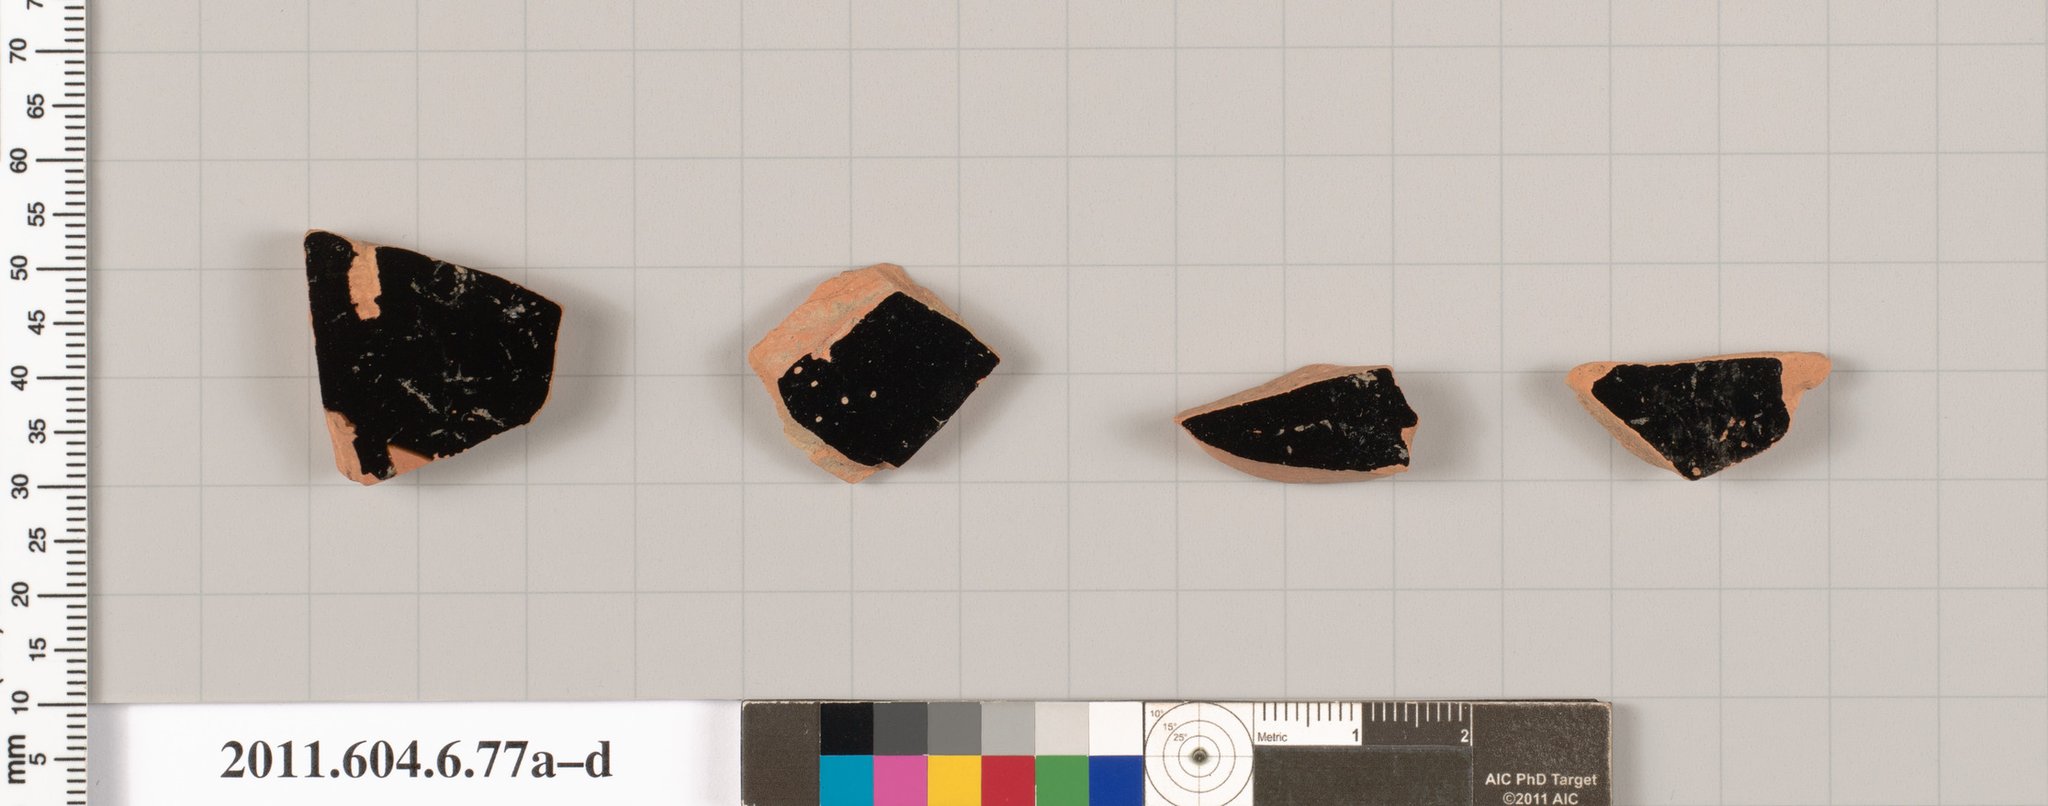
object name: undetermined open shape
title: Terracotta fragments of open shapes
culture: greek, attic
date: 600-401 BCE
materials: terracotta